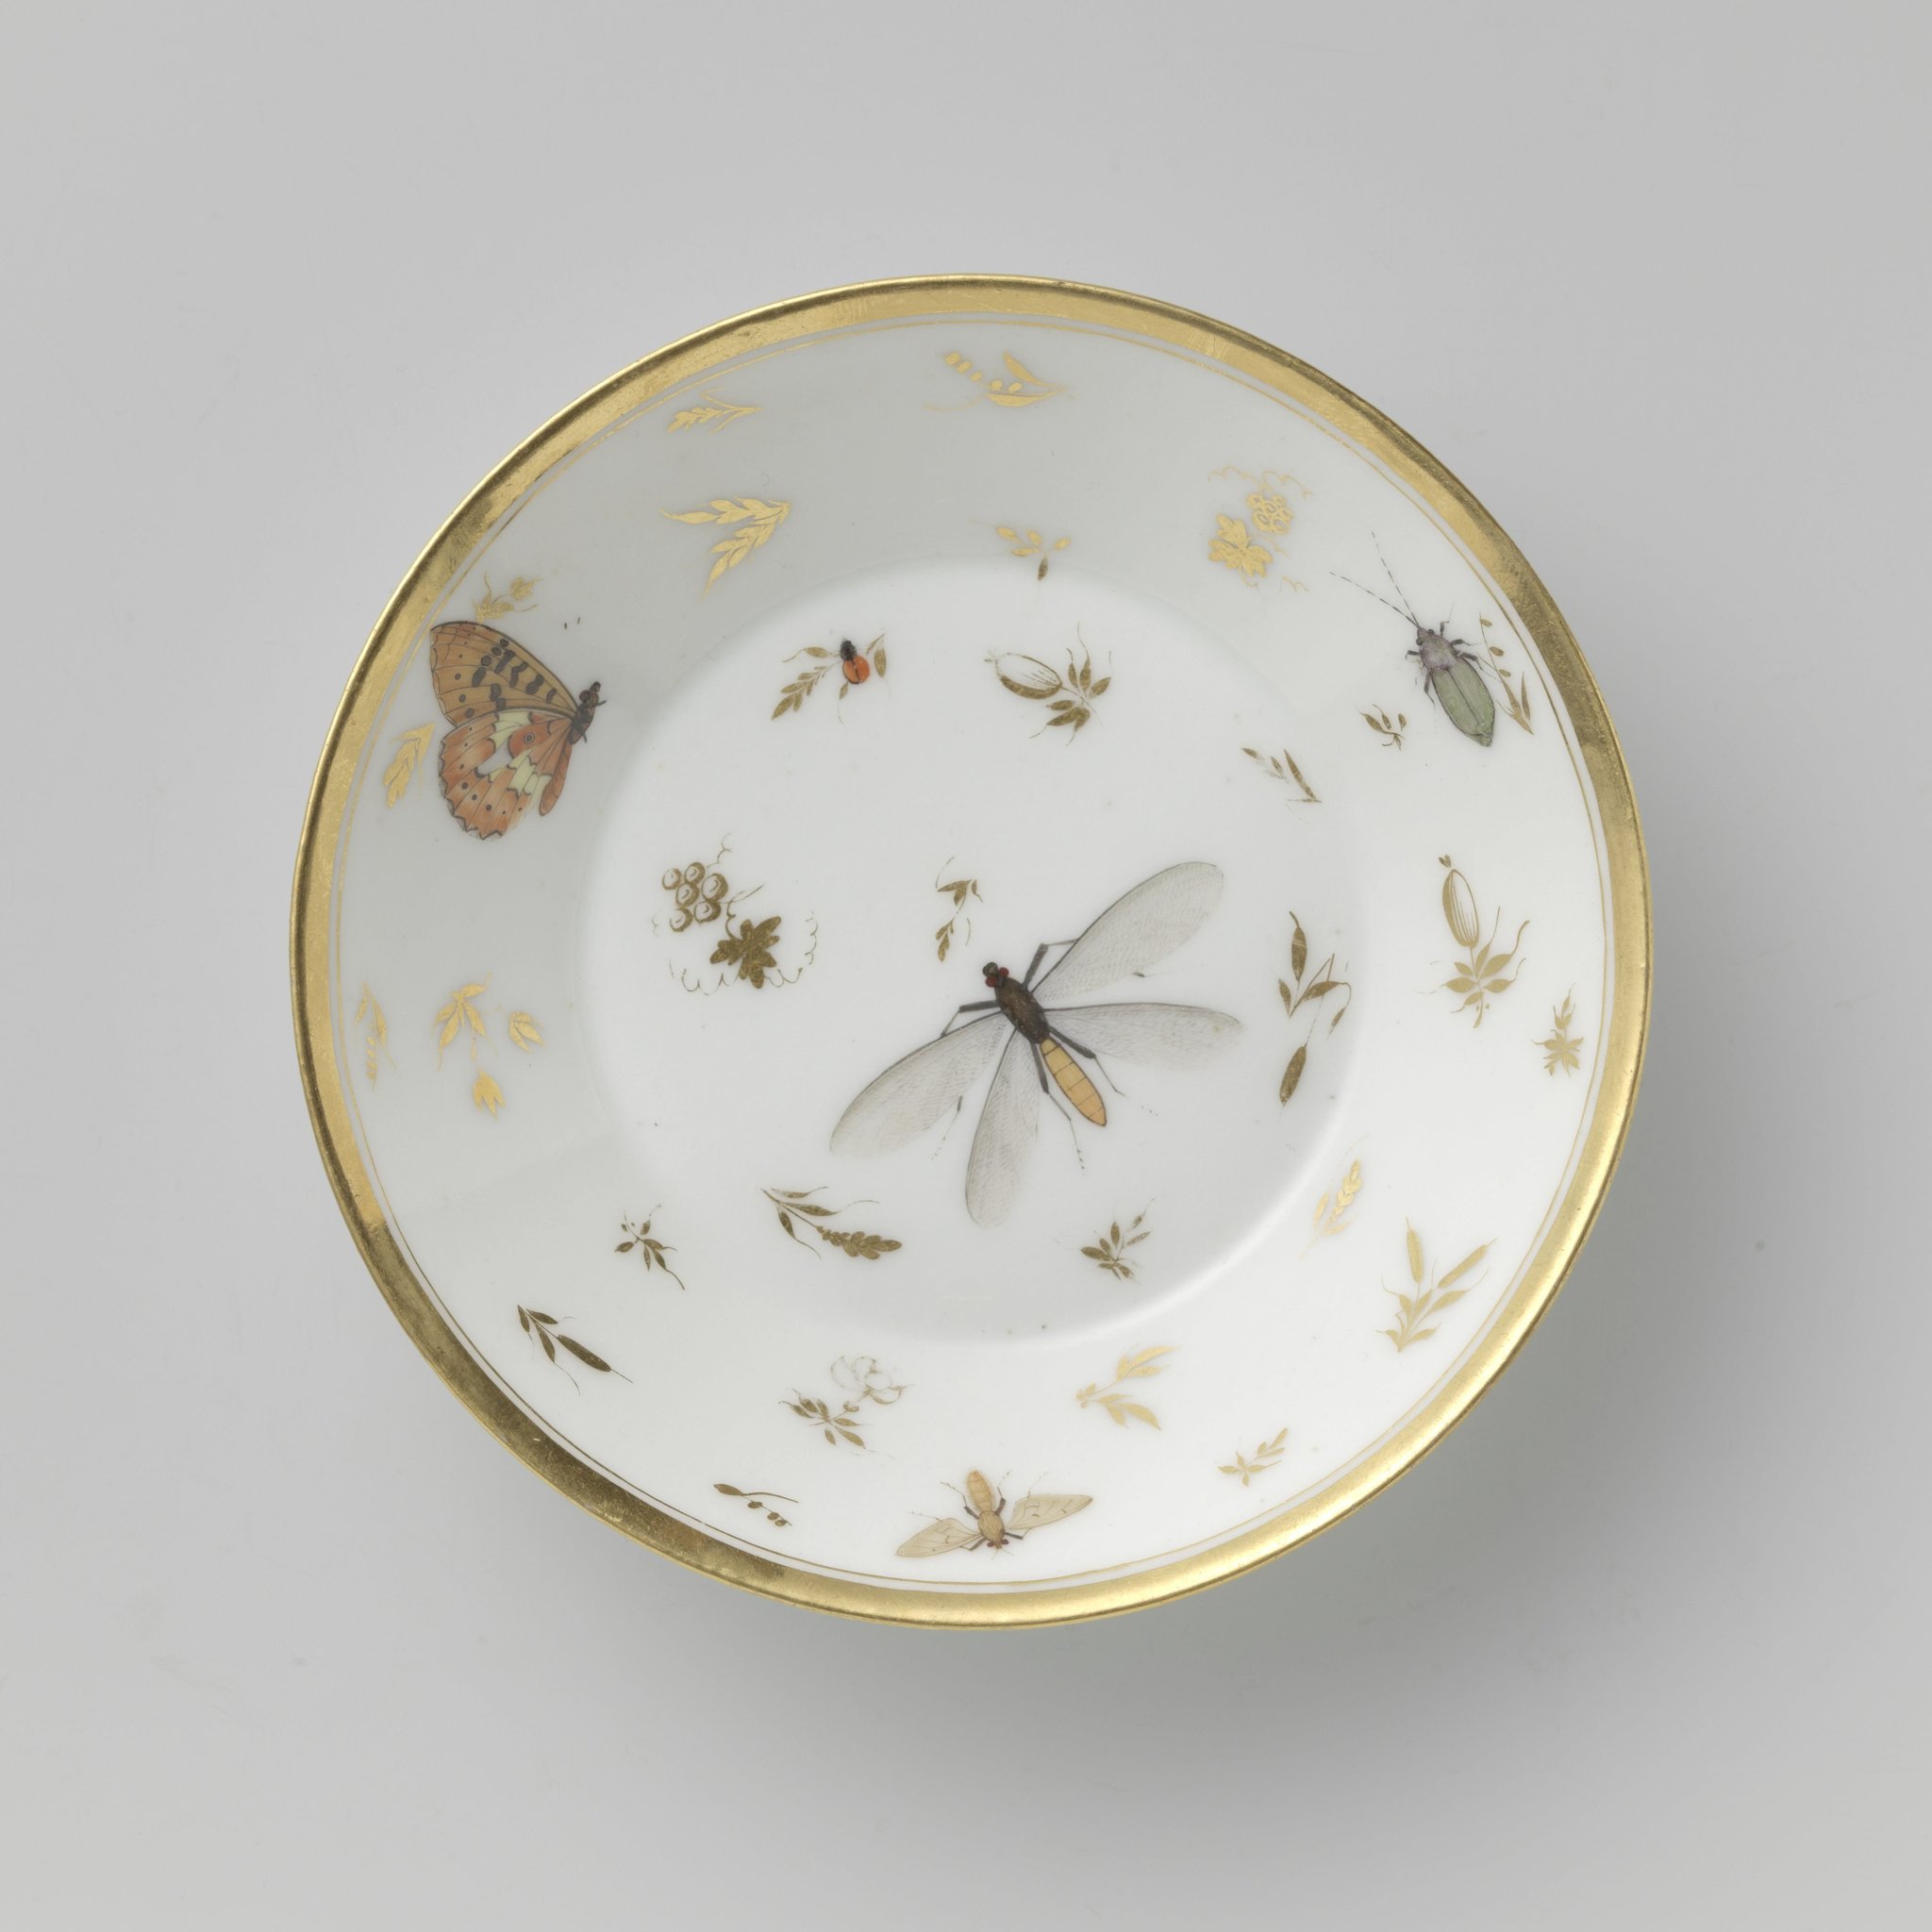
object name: service set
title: Saucer with insects, flower sprays and grapevines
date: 1797-1798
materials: glaze, gold, paint, porcelain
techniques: firing, forming, gilding, turning, vitrification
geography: paris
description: Schotel van porselein met een rechte wand, beschilderd op het glazuur in emailkleuren en goud. De voorzijde is bedekt met gekleurde insecten (vlinders, kevers, libellen, etc.) en in goud bloemtakken en druivenranken. Gouden rand.